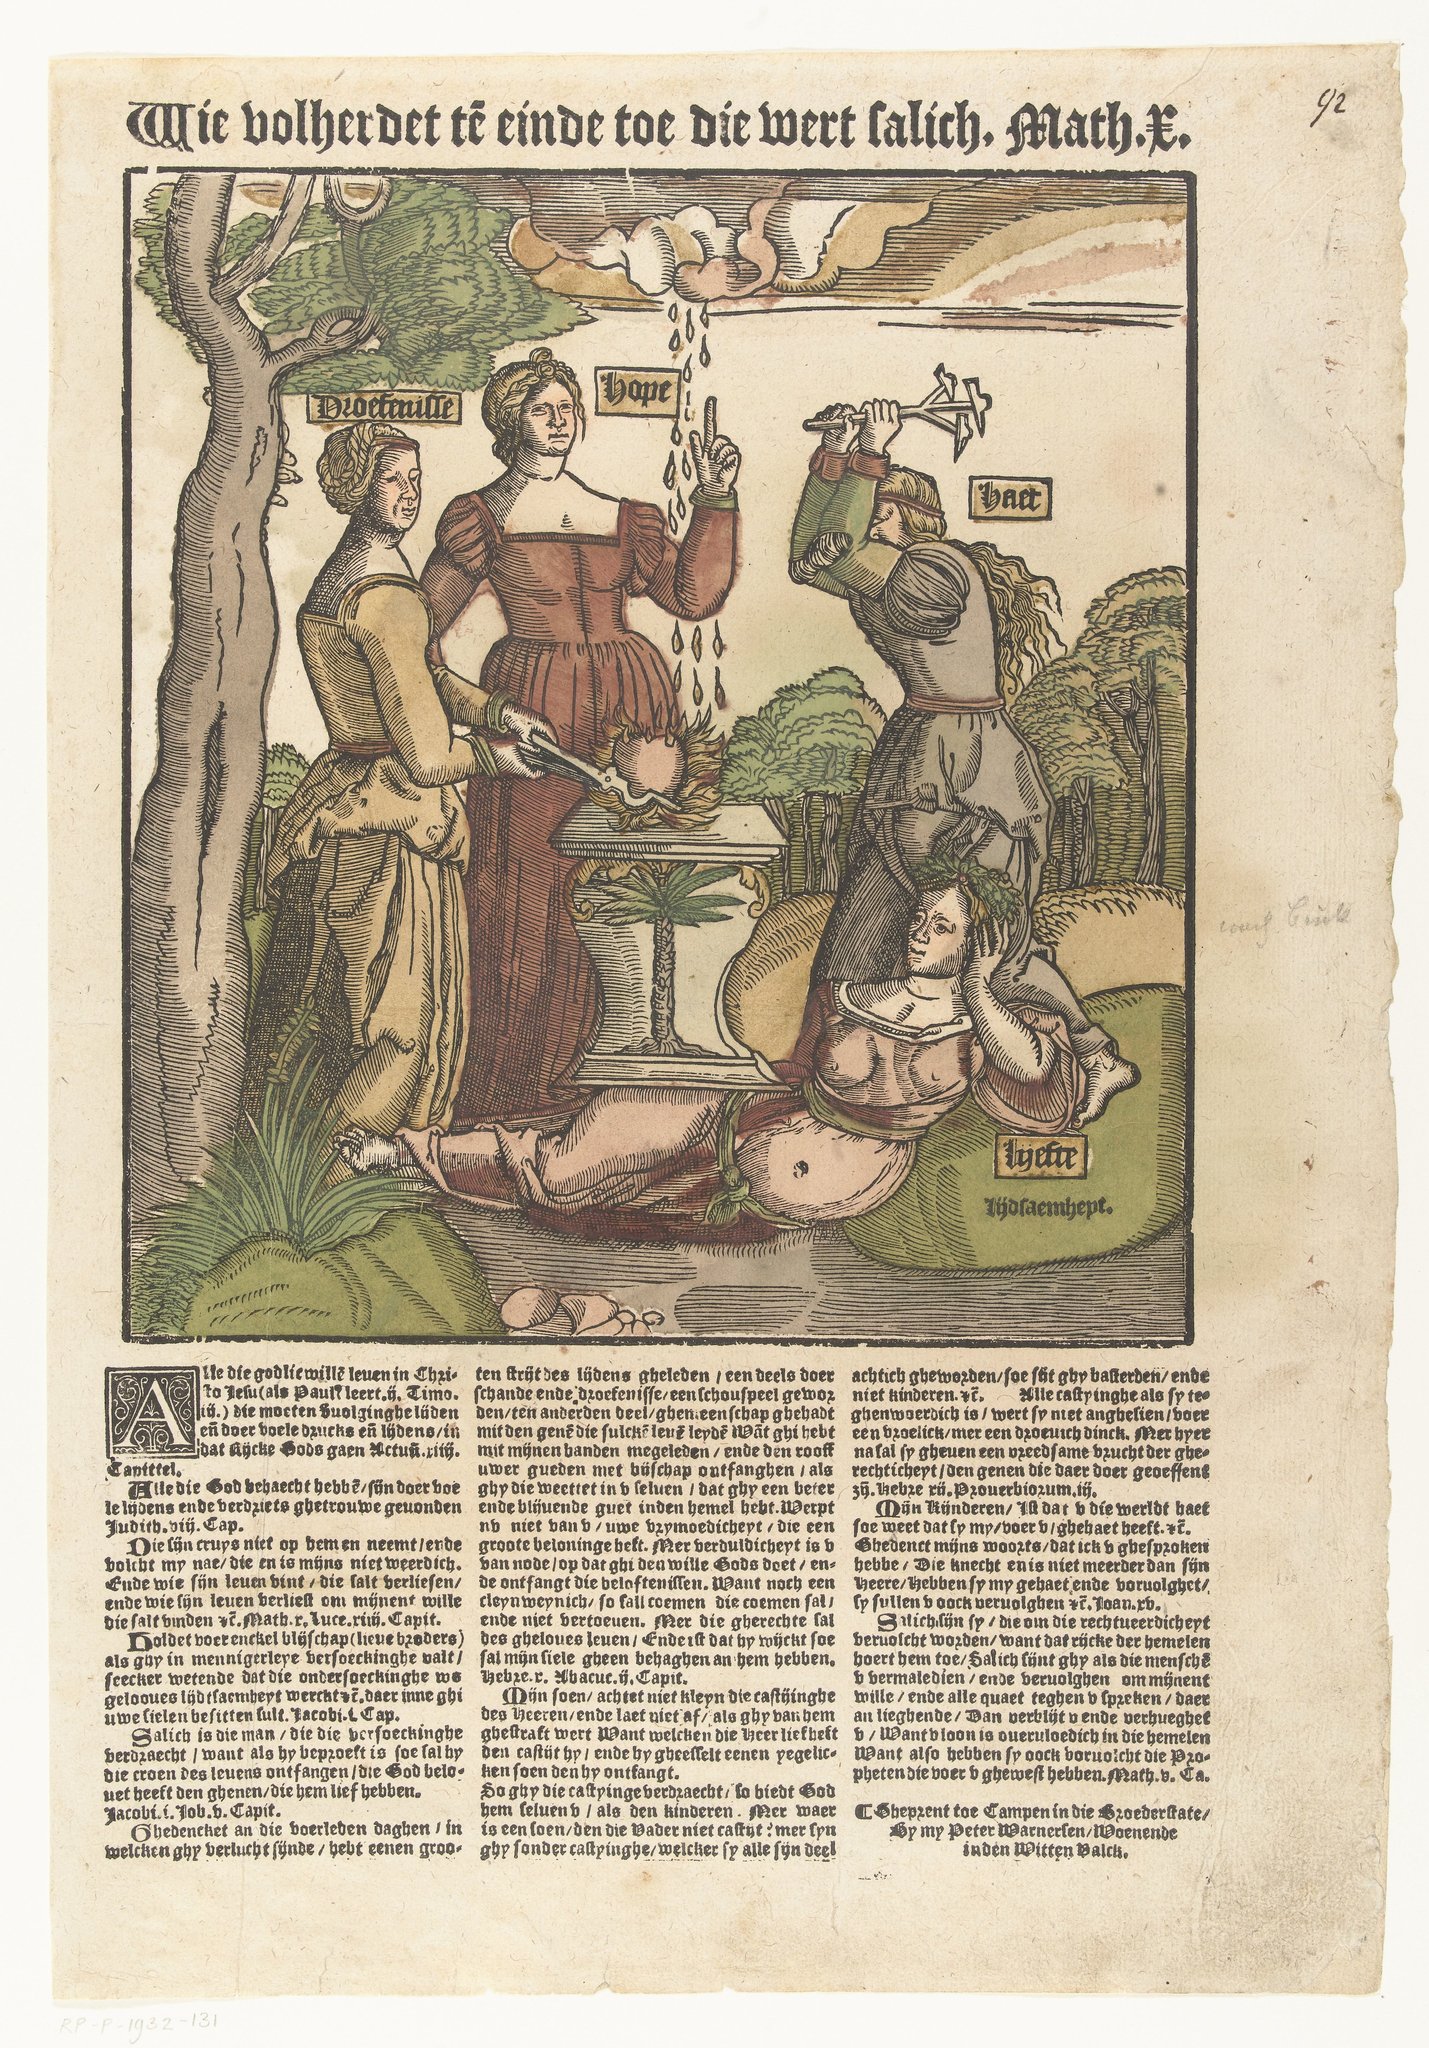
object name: print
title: Wie volherdet te[n] einde toe die wert salich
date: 1540-1567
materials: paper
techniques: hand coloring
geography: low countries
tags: hate; 'odio capitale' (ripa), patience; 'patienza' (ripa), pain, sorrow, sadness; 'dolore', 'dolore di zeusi' (ripa), hope; 'speranza', 'speranza delle fatiche' (ripa)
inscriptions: number: ‘92’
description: Vier vrouwen die Droevenis, Haat, Hoop en Lijdzaamheid verbeelden. Droevenis en Haat smeden een hart. Onder afbeelding drie kolommen tekst in het Nederland.